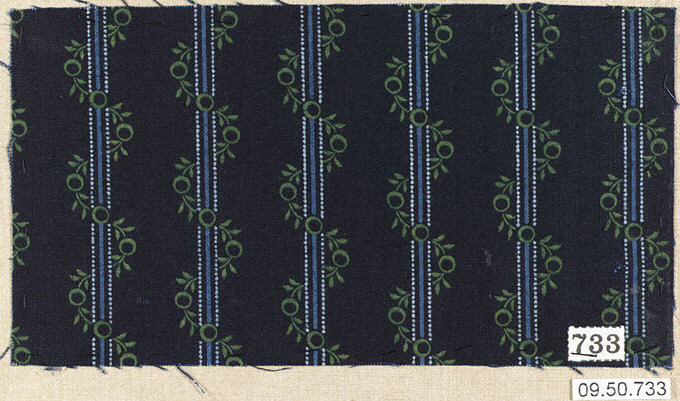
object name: piece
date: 1801-1900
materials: cotton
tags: leaves